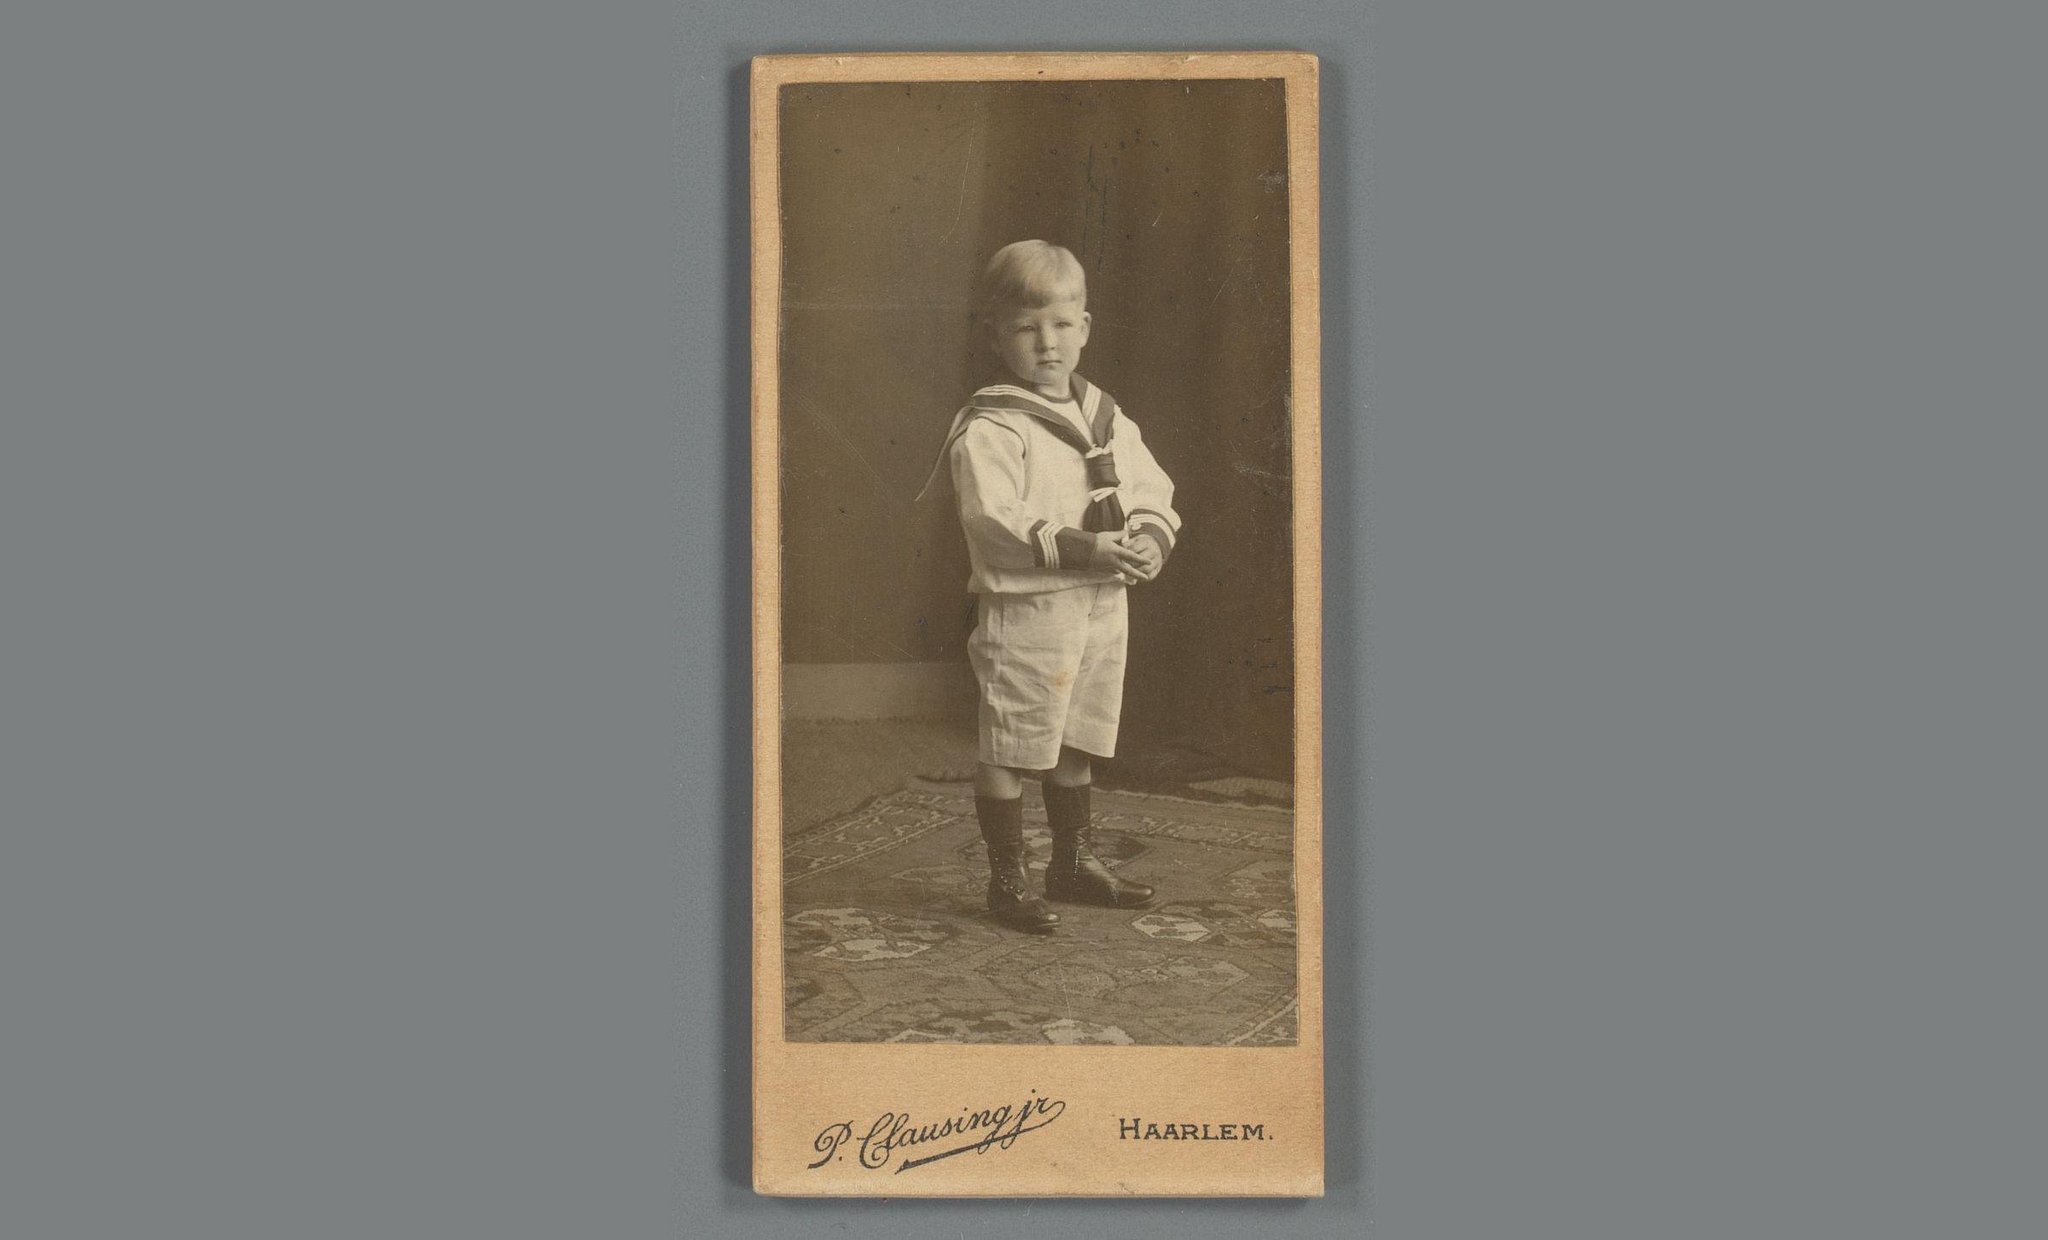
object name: photograph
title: Miniatuurportret van een onbekende jongen in matrozenpak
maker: peter clausing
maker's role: fotograaf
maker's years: 1870-1913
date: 1908-1913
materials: paper, cardboard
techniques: gelatin silver print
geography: haarlem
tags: ensemble of pieces of clothing: sailor suit, boy (child between toddler and youth), anonymous historical person portrayed, haarlem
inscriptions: inscription: ‘P. Clausing jr/ Haarlem/ Baan 9B/ Onderscheidingen (...) 10203 Prager & Lojda, Berlin.’, inscription: ‘P. Clausing jr/ Haarlem.’